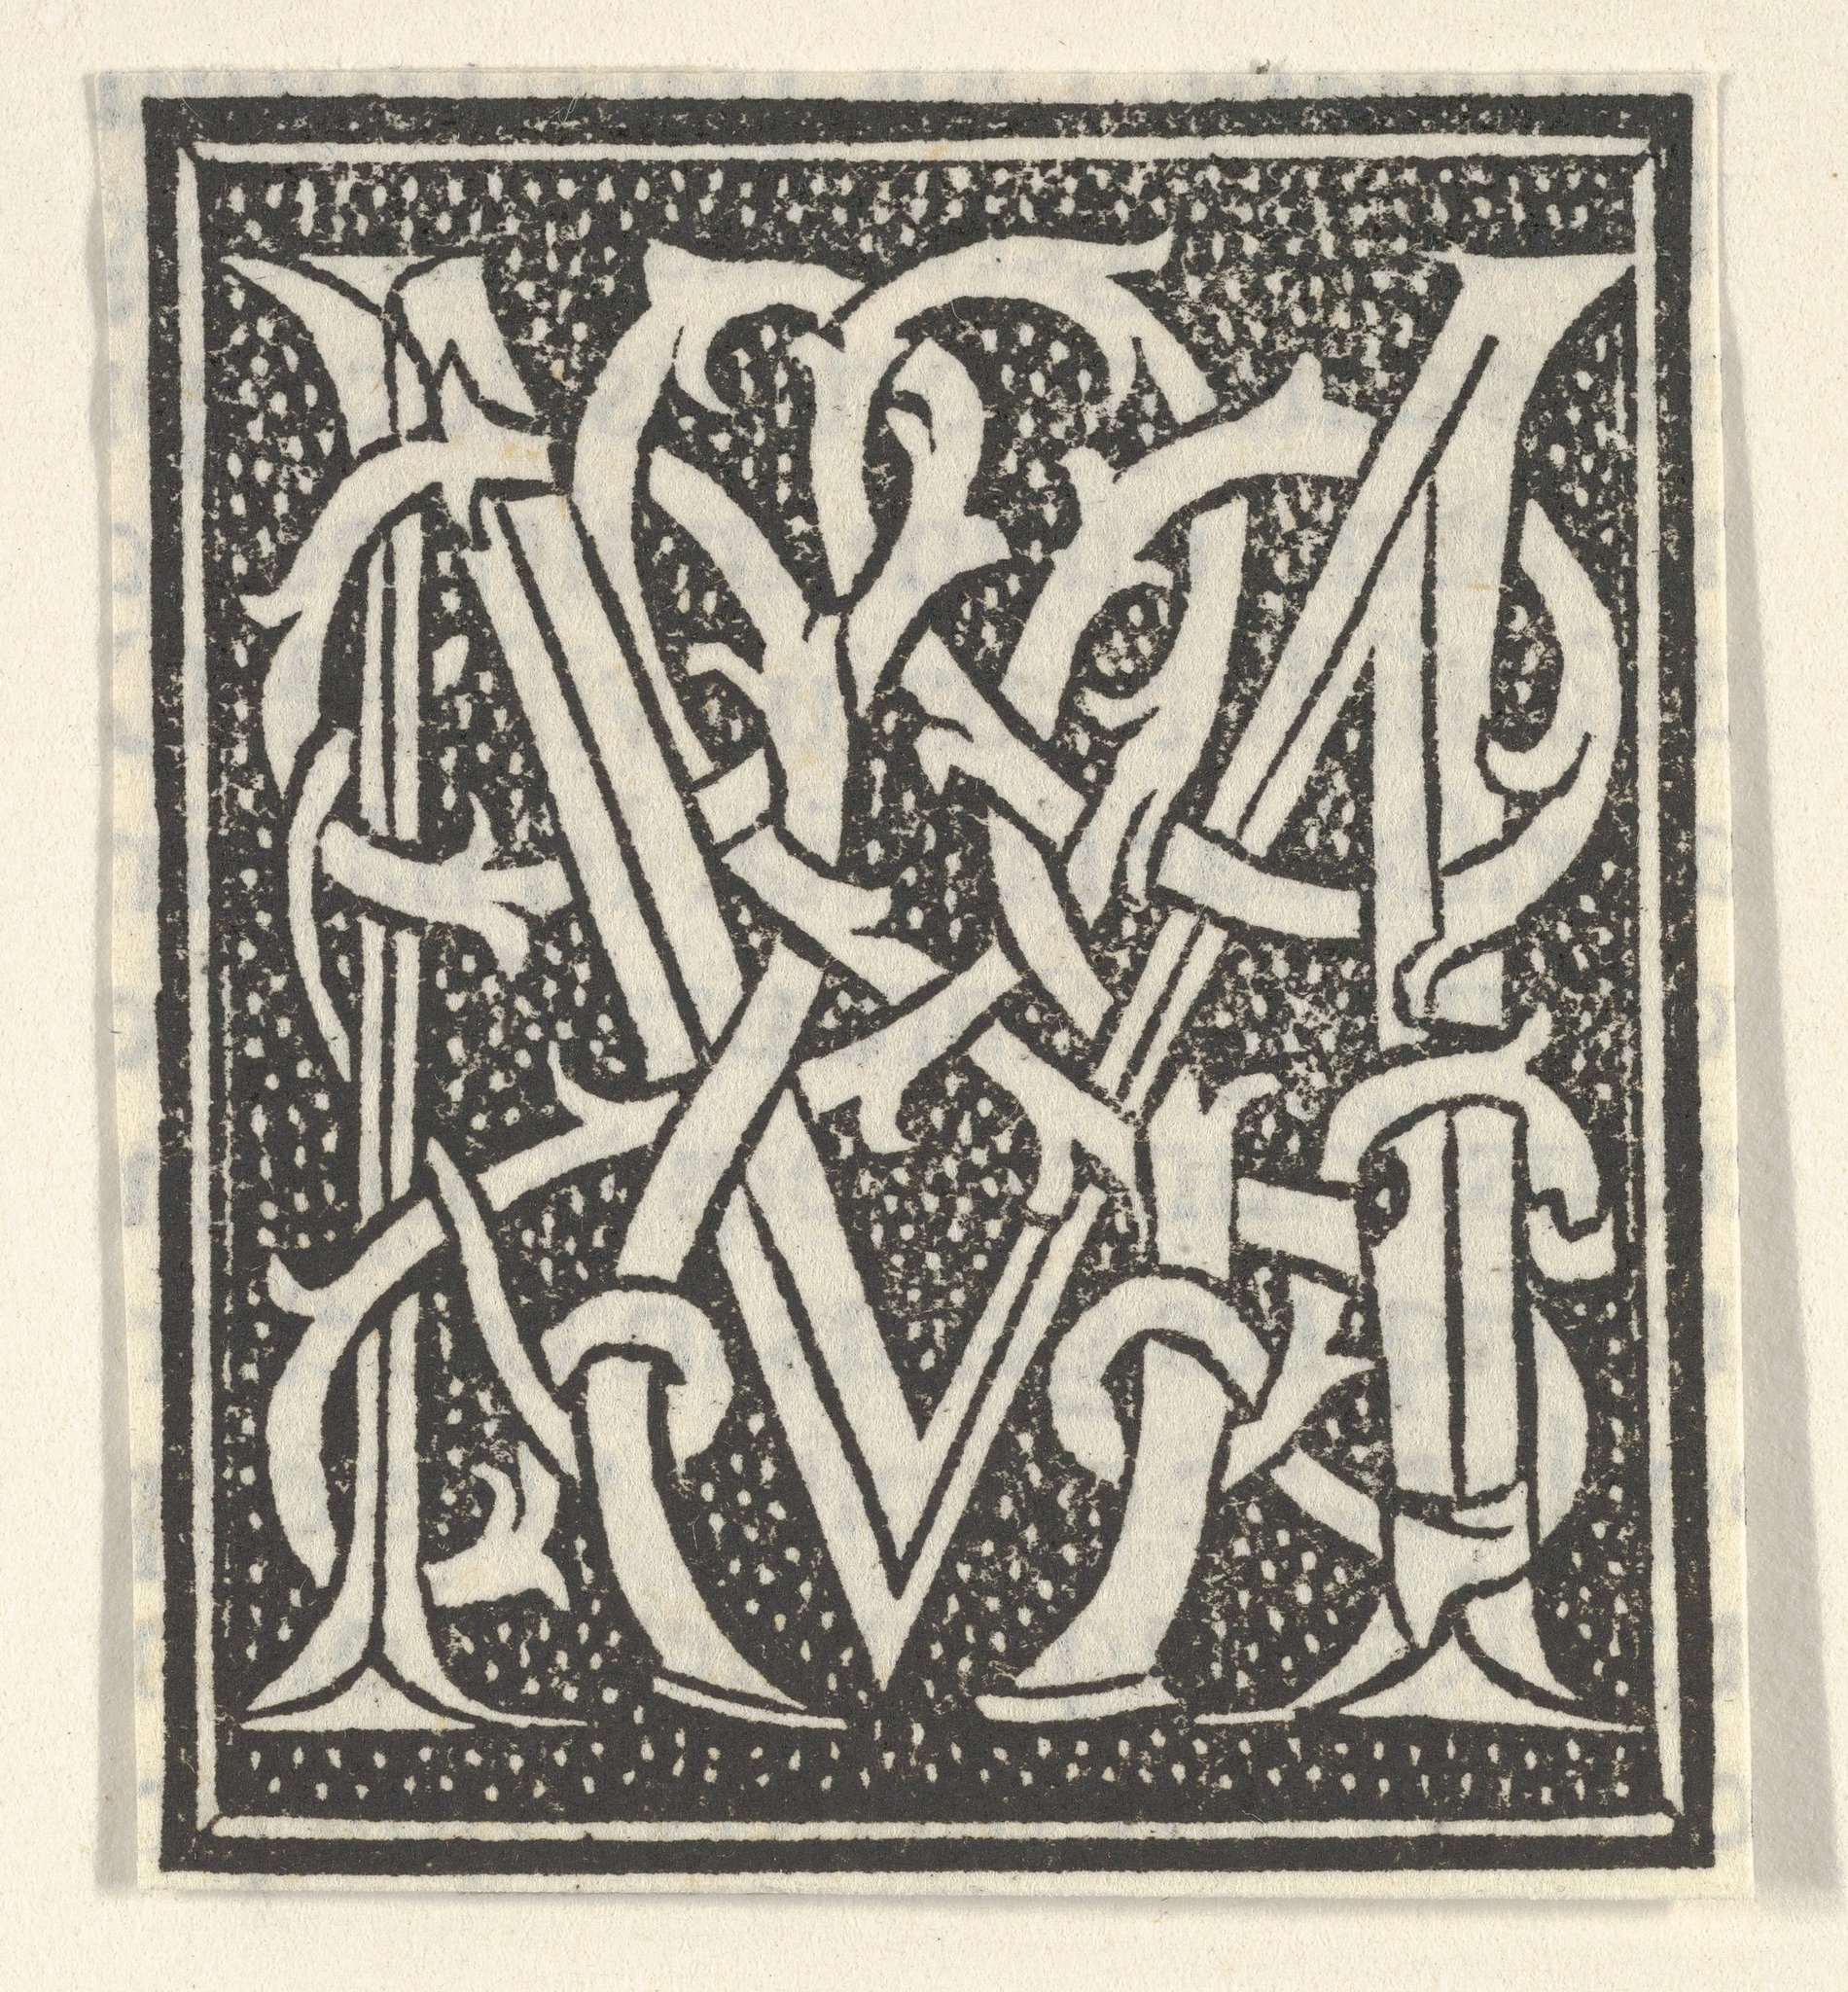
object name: print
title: Initial letter M on patterned background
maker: anonymous, italian, 16th century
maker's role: artist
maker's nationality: italian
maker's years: 1500-1600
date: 1520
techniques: woodcut